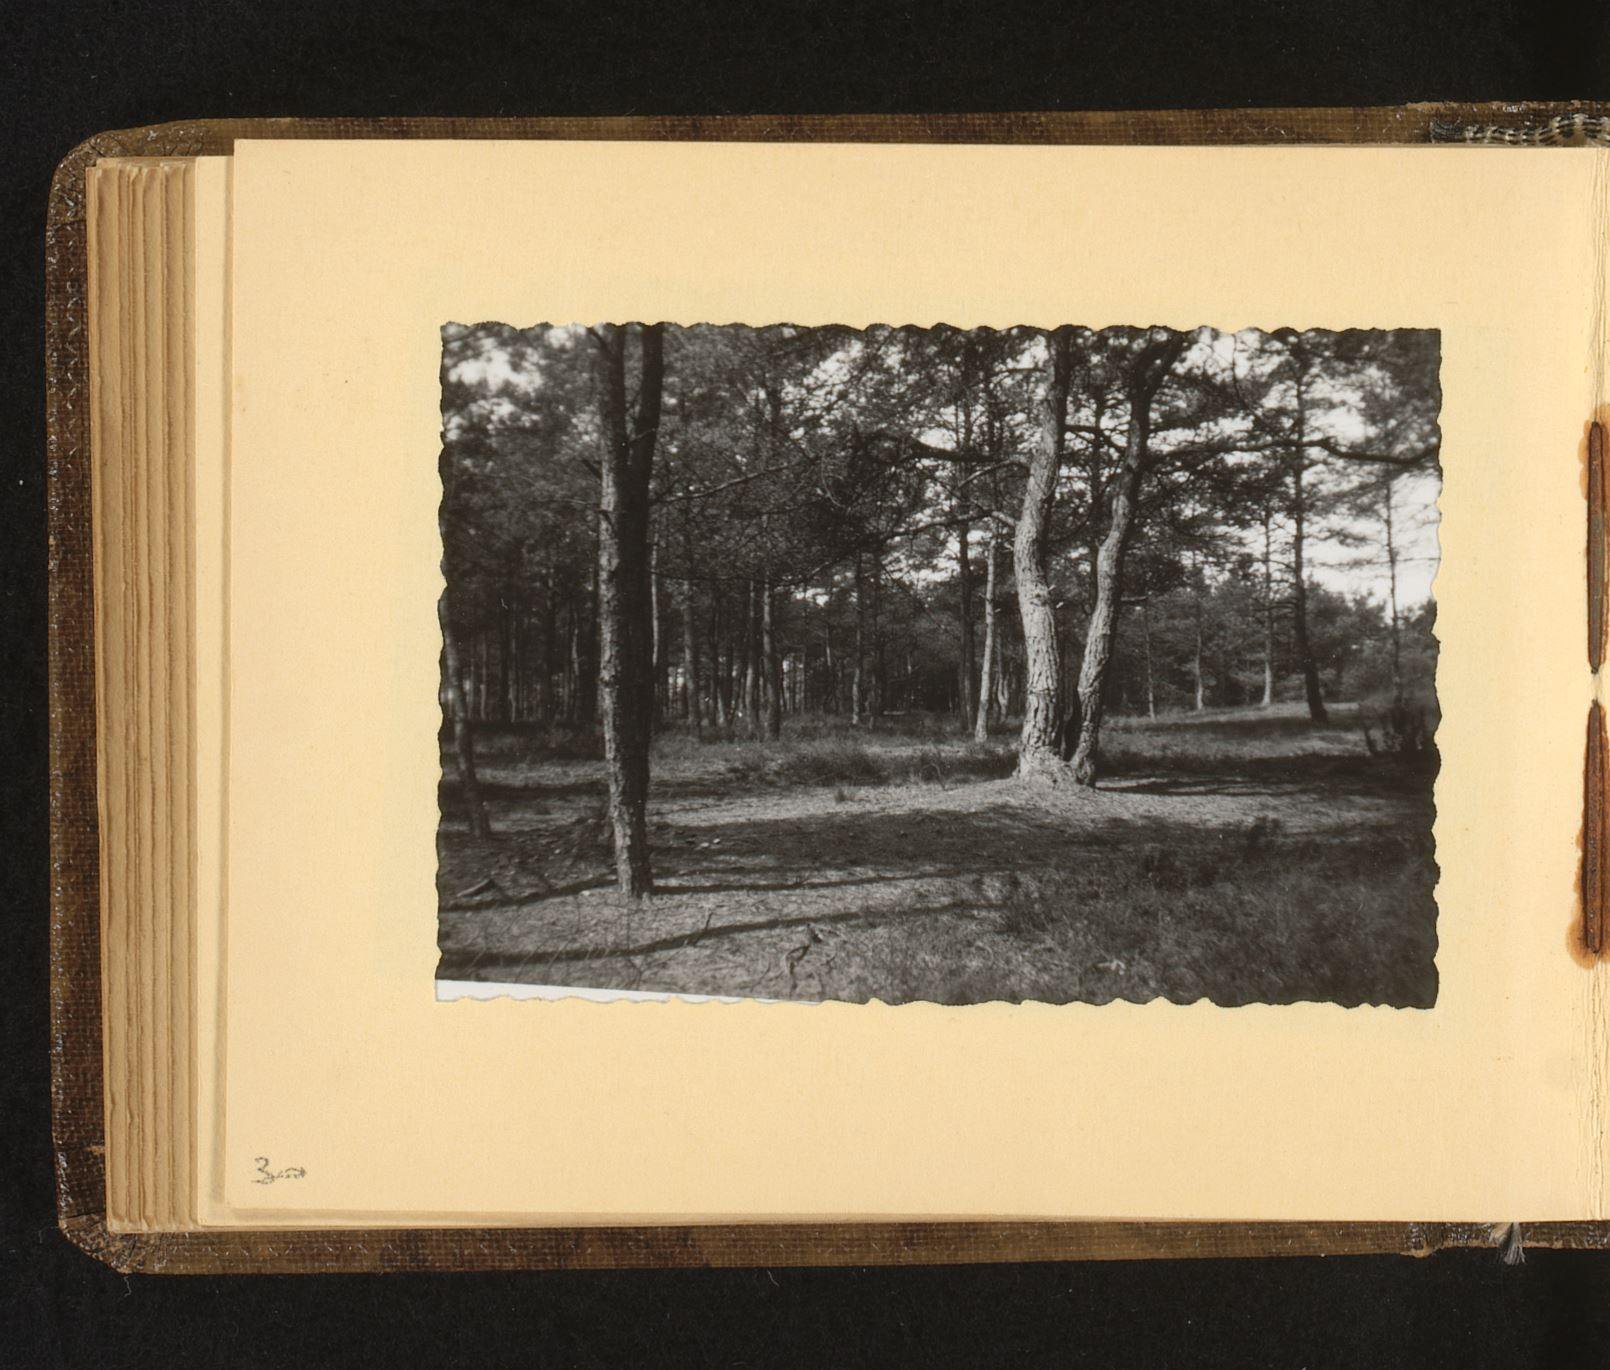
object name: album leaf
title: Boslandschap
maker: Anonymous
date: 1939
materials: cardboard, photographic support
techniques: gelatin silver print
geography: gelderland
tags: family life at home, open-air recreation, gelderland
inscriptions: inscription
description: Albumblad met een foto van een boslandschap in het natuurgebied De Vennebulten. Onderdeel van het familiealbum 1938-1939.